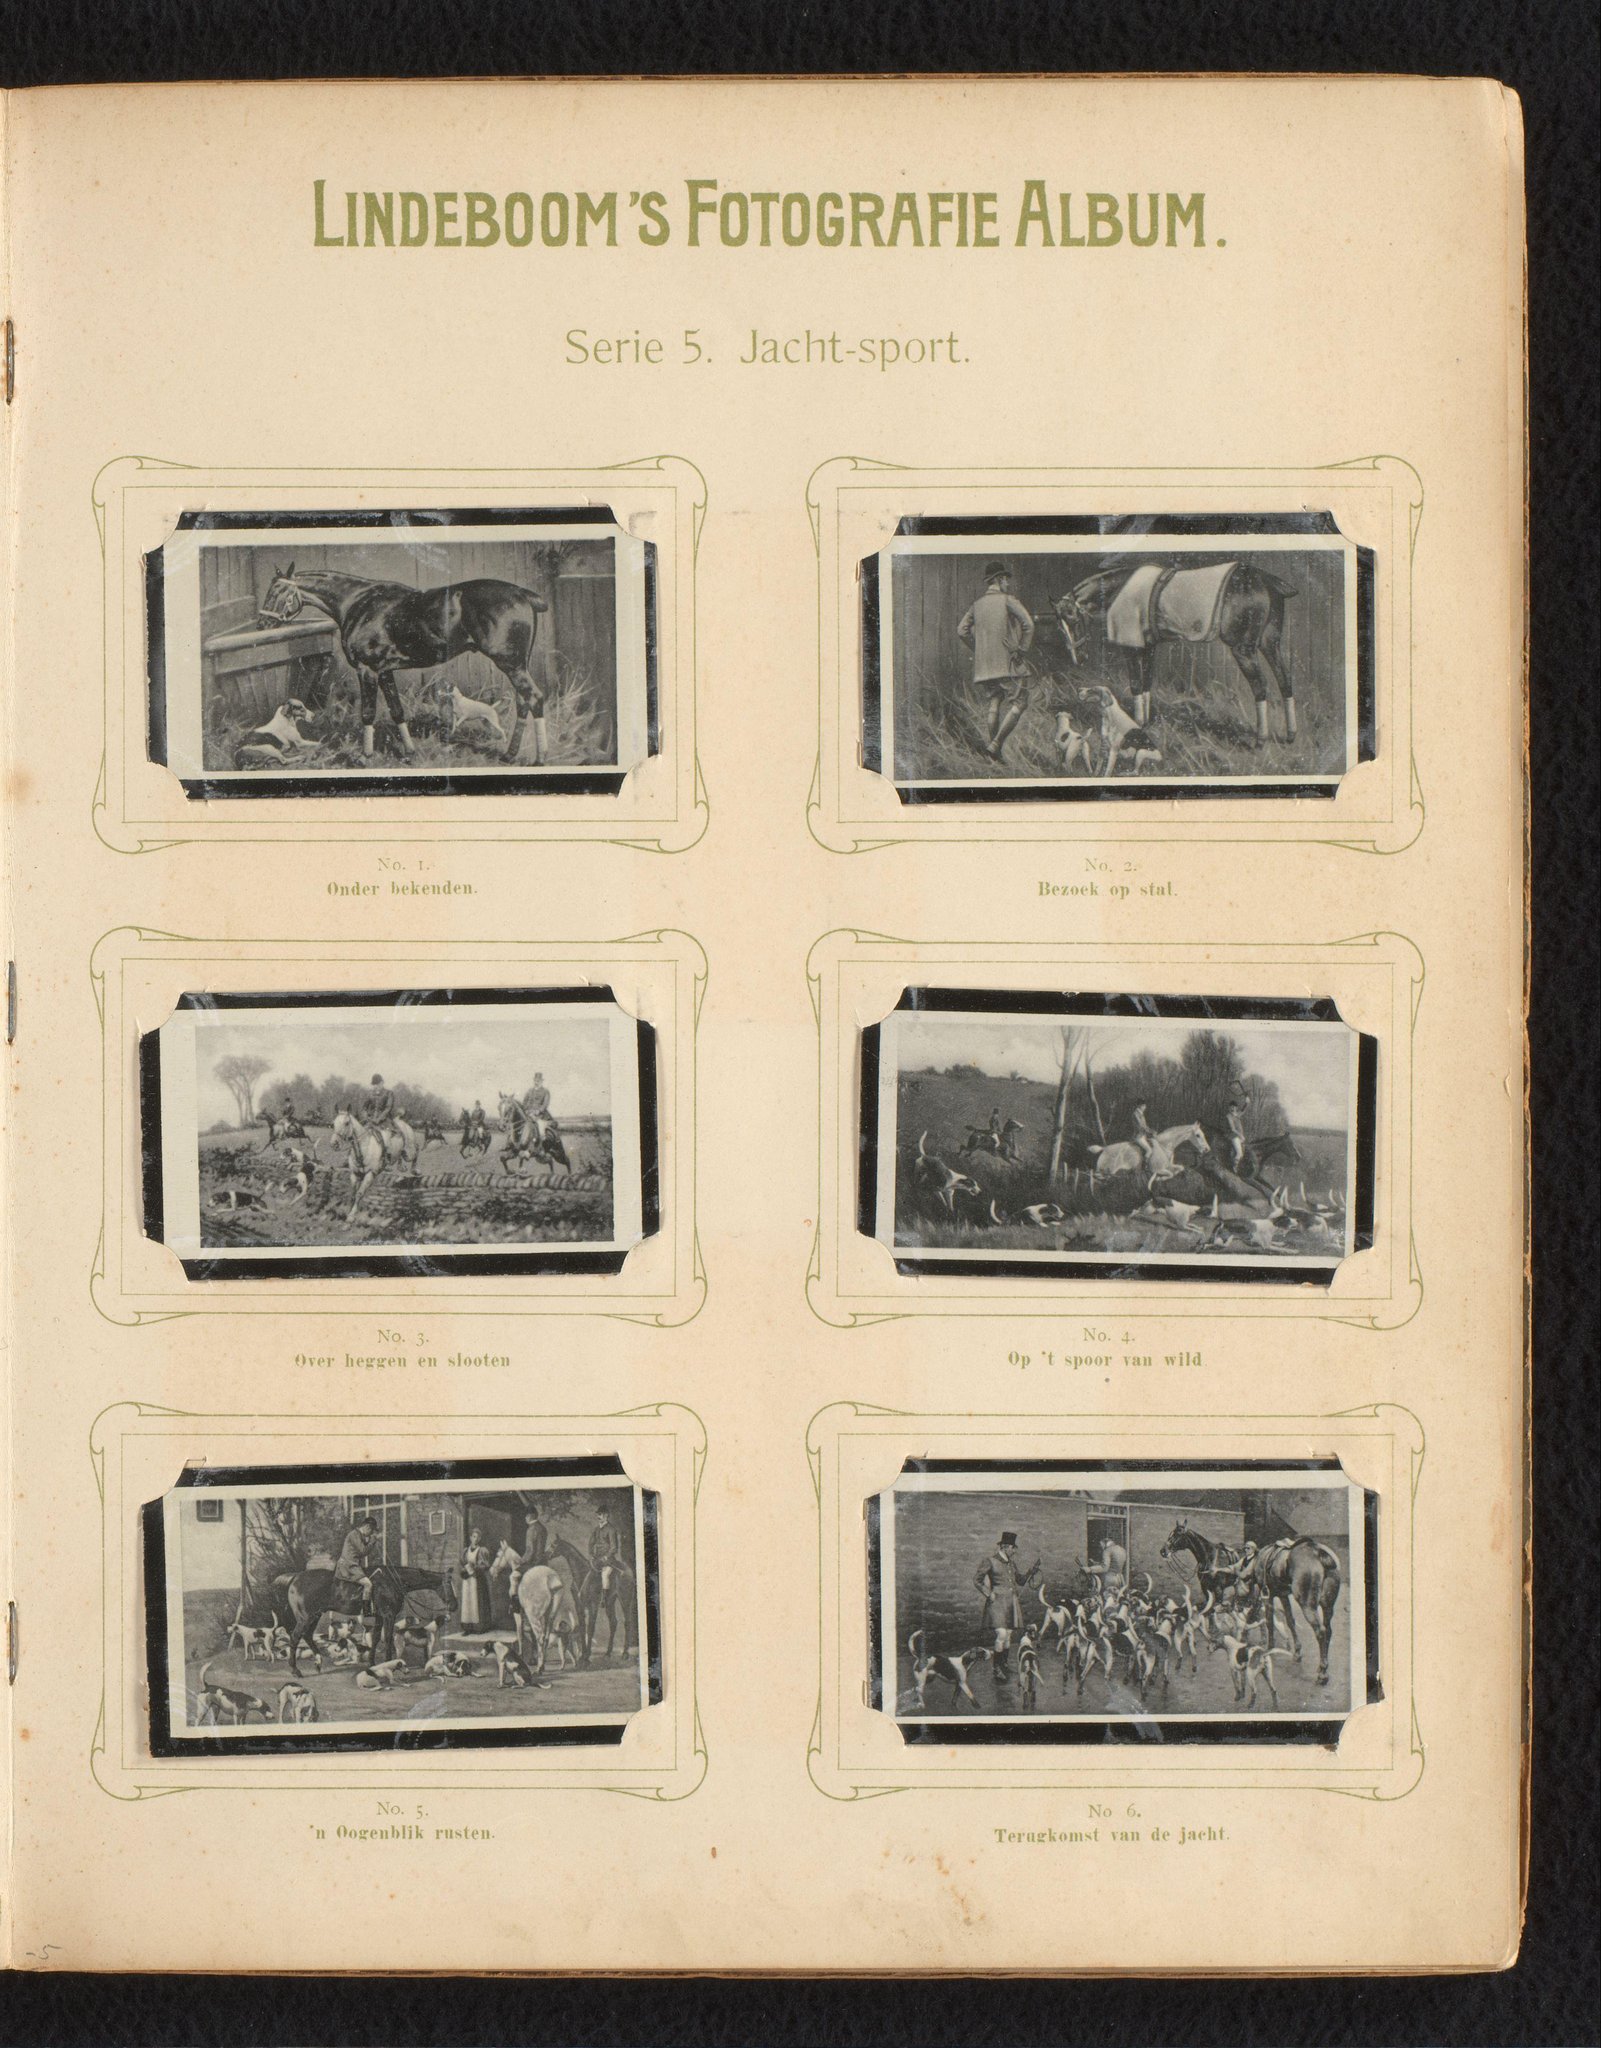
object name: album leaf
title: Jacht-sport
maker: Anonymous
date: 1905-1906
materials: cardboard, paper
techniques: photograph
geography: amsterdam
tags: hunting dogs, hunters hunting (n.b.: in 1988-1990 this notation denoted the concept of 43c11421 'hunters resting during the hunt'), horse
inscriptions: inscription: ‘Serie 5.’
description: Dergelijke prenten stonden bekend als 'zwartjes'. Men verkreeg ze bij aanschaf van bepaalde merken thee, cacao, sigaretten, beschuit, etc. om te verzamelen. Er waren speciaal voor de 'zwartjes' vervaardigde verzamelalbums in omloop.